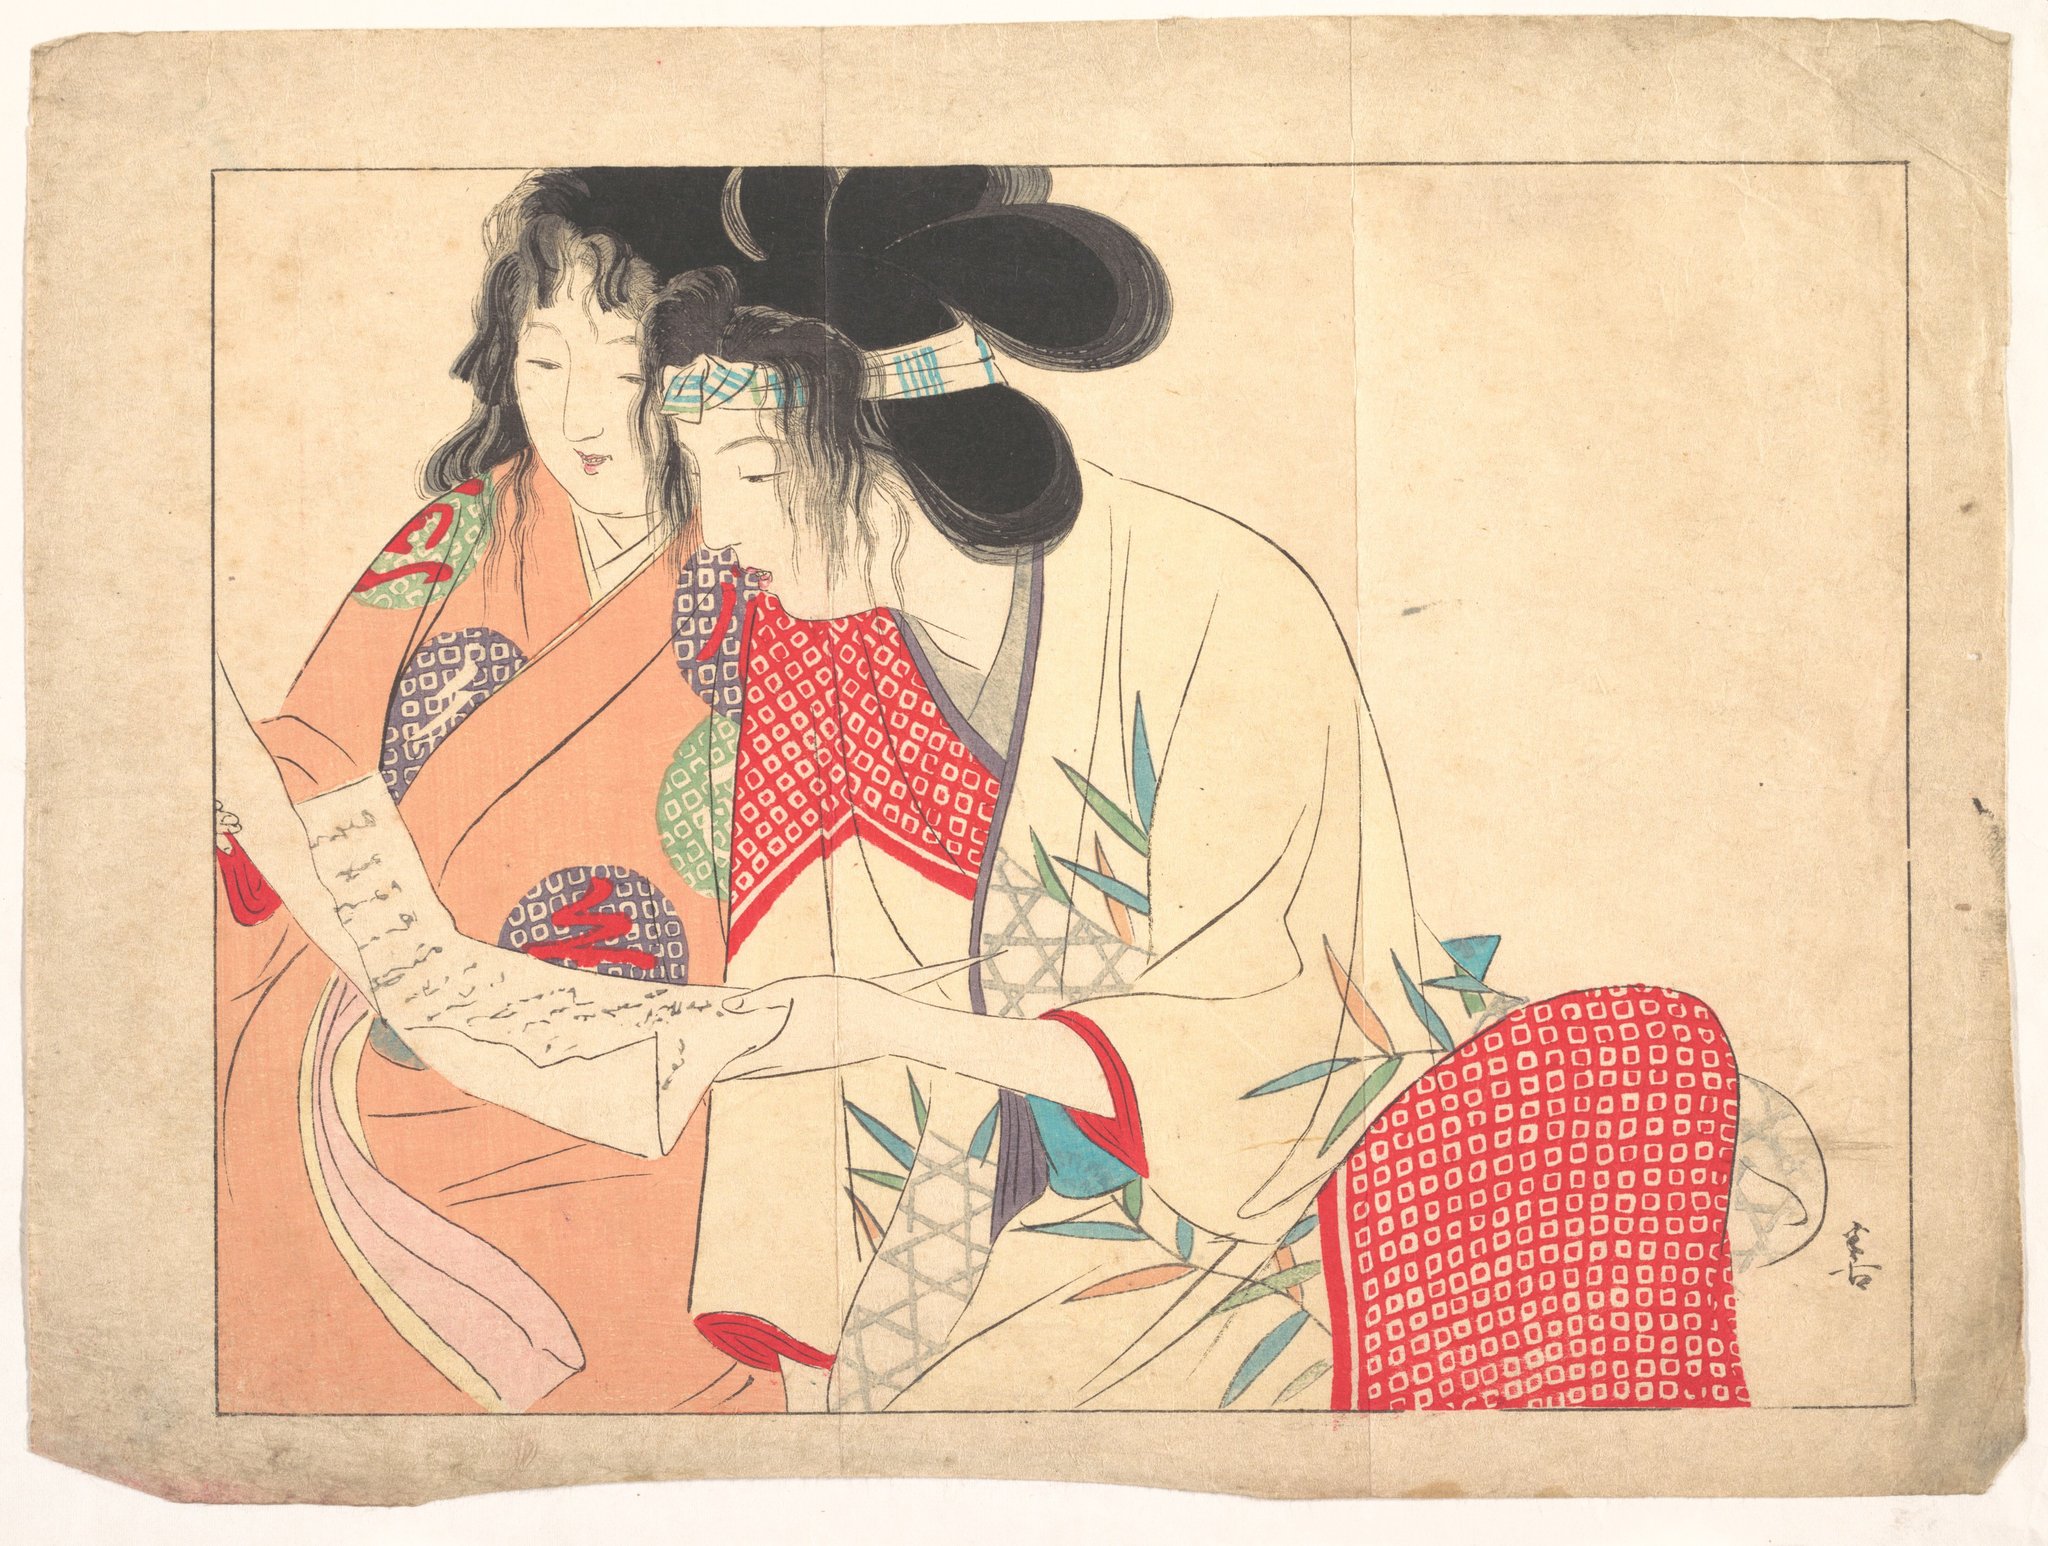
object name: print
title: Love Letter (Kesobumi)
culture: japanese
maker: kajita hanko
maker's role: artist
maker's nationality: japanese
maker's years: 1870-1917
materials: ink, paper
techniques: woodblock print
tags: women,reading